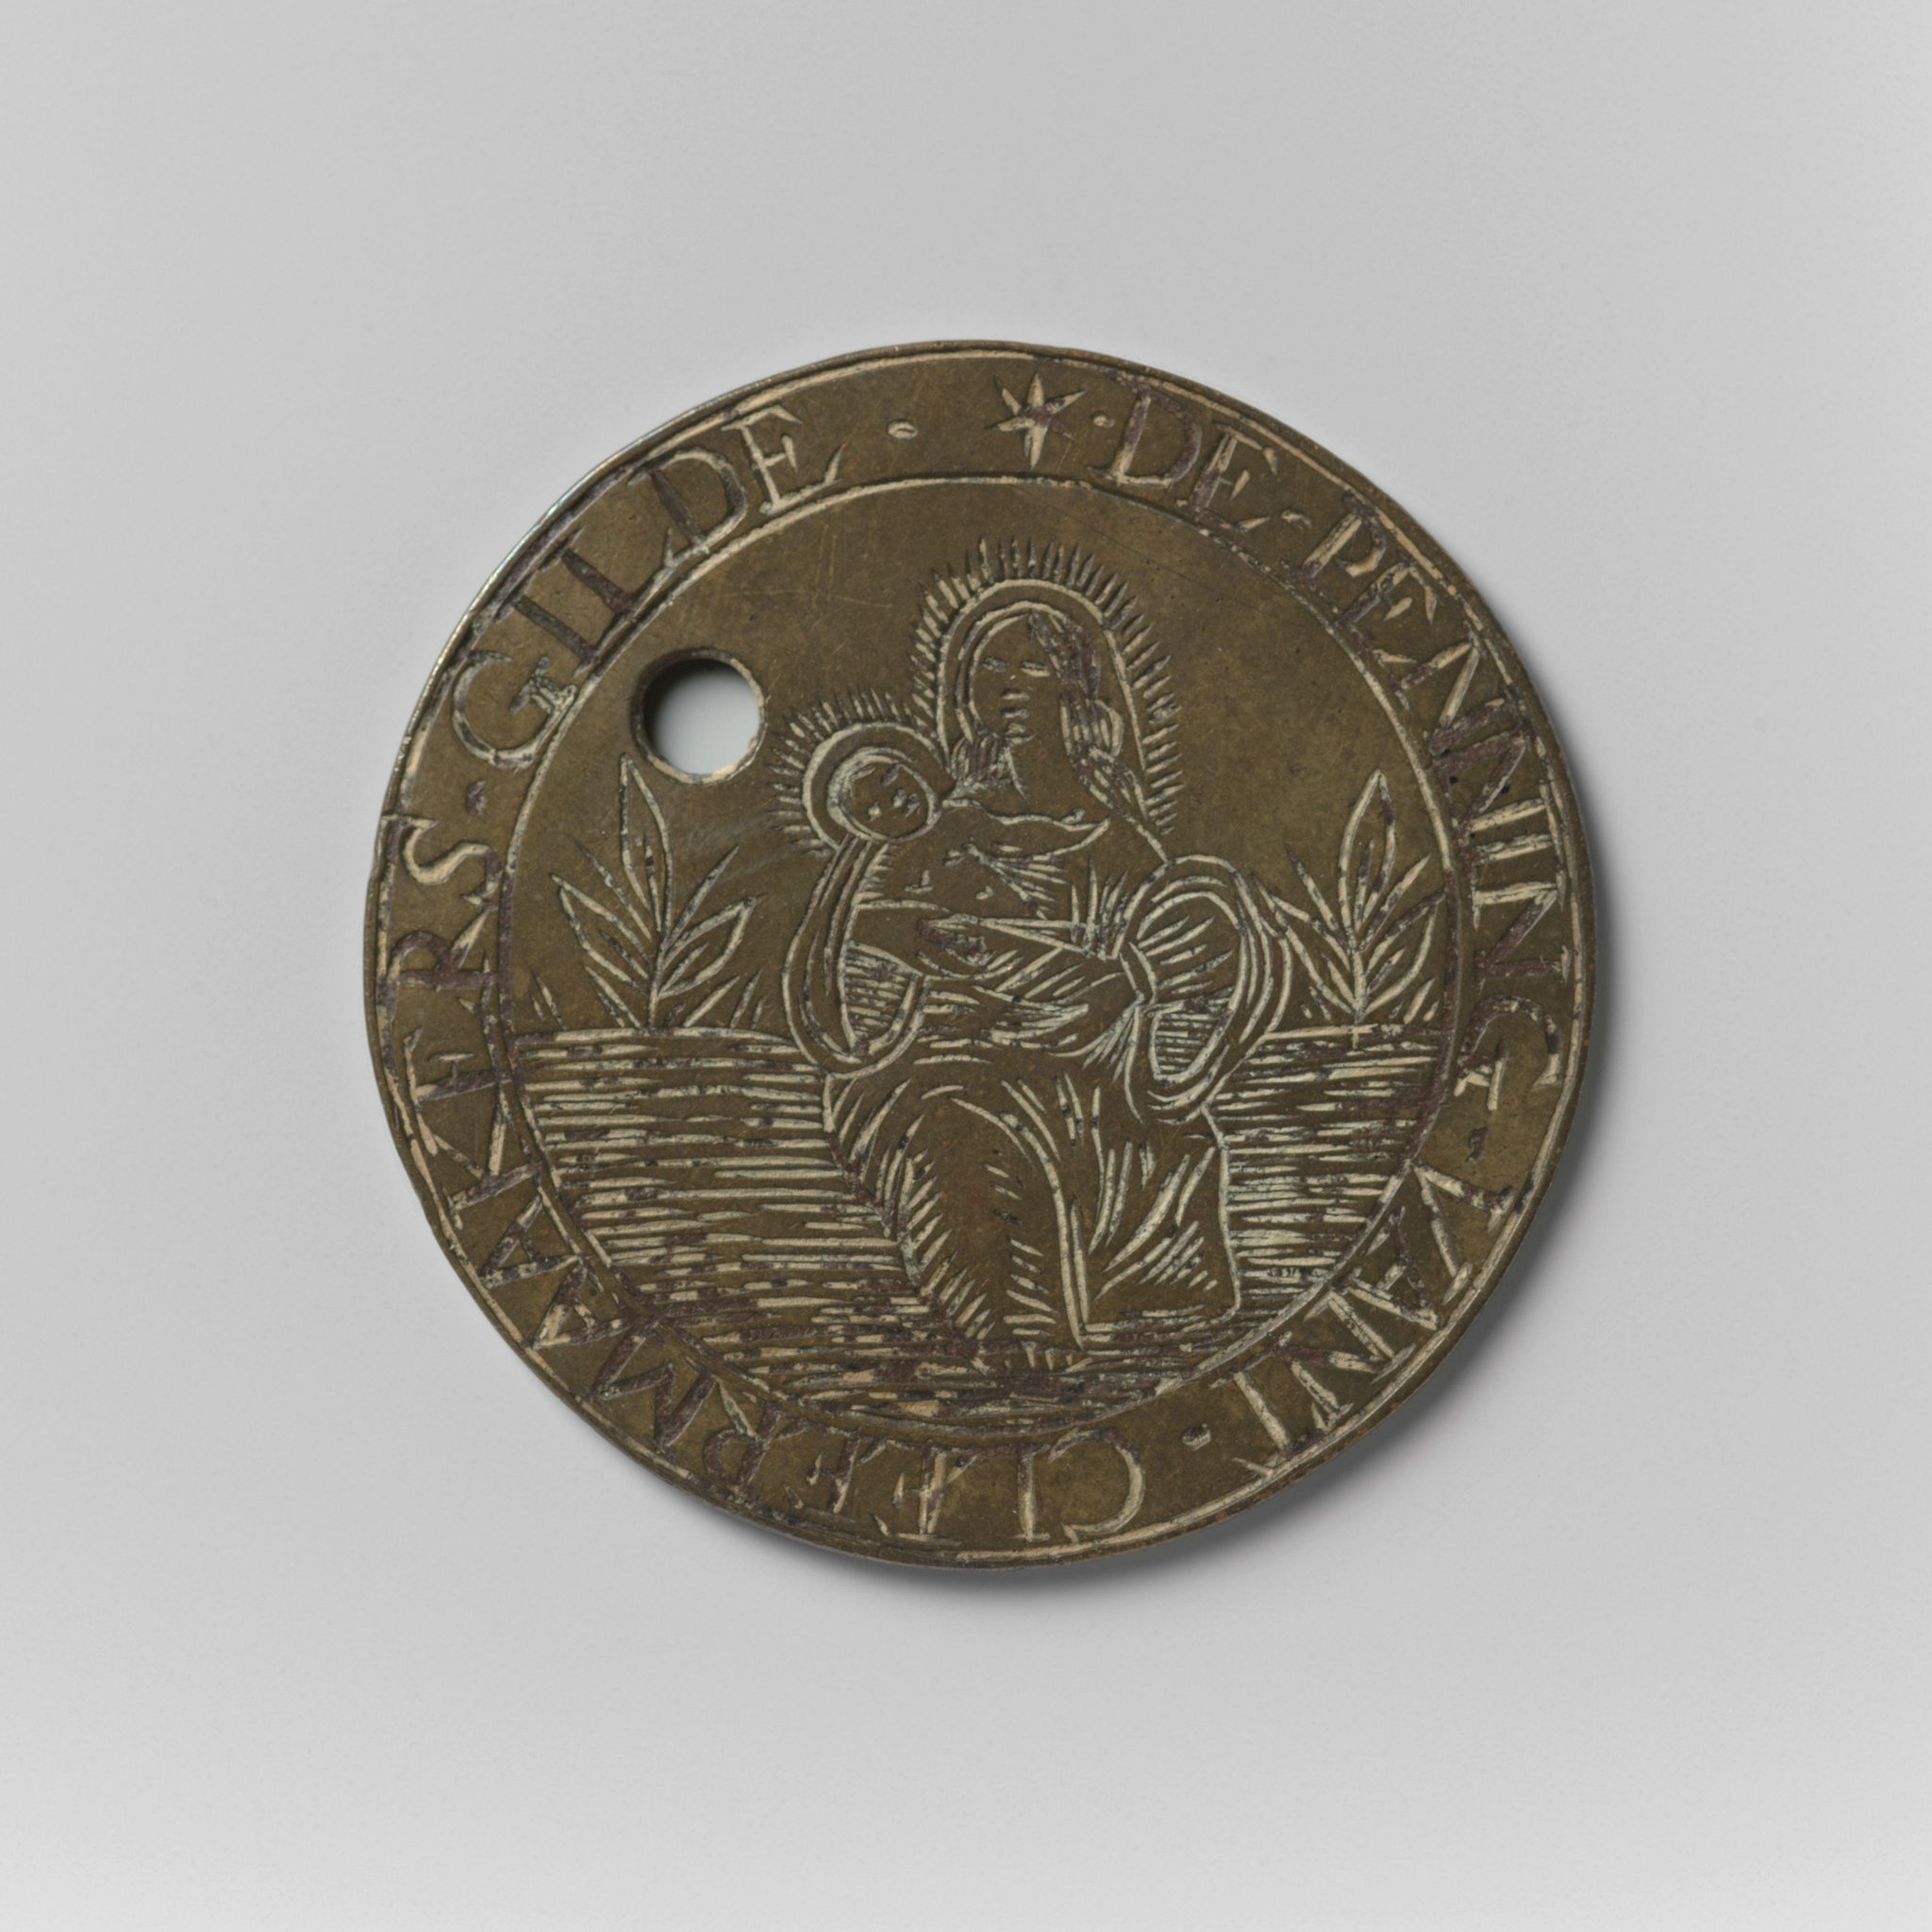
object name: history medal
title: Presentiepenning van het Kleermakersgilde te Delft, 1669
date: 1669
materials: brass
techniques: engraving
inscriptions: circumscription: ‘(ster) .DE.PENNING.VANT.CLEERMAAKERS.GILDE.’, circumscription: ‘.GV. - .IK. - .BK. - .MH. - .1669.’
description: Ronde plaat messing, gegraveerd op de voorzijde Maria met kind in een landschap, met omschrift, op de keerzijde een gekroonde schaar, het getal 41 en een omschrift, met gat